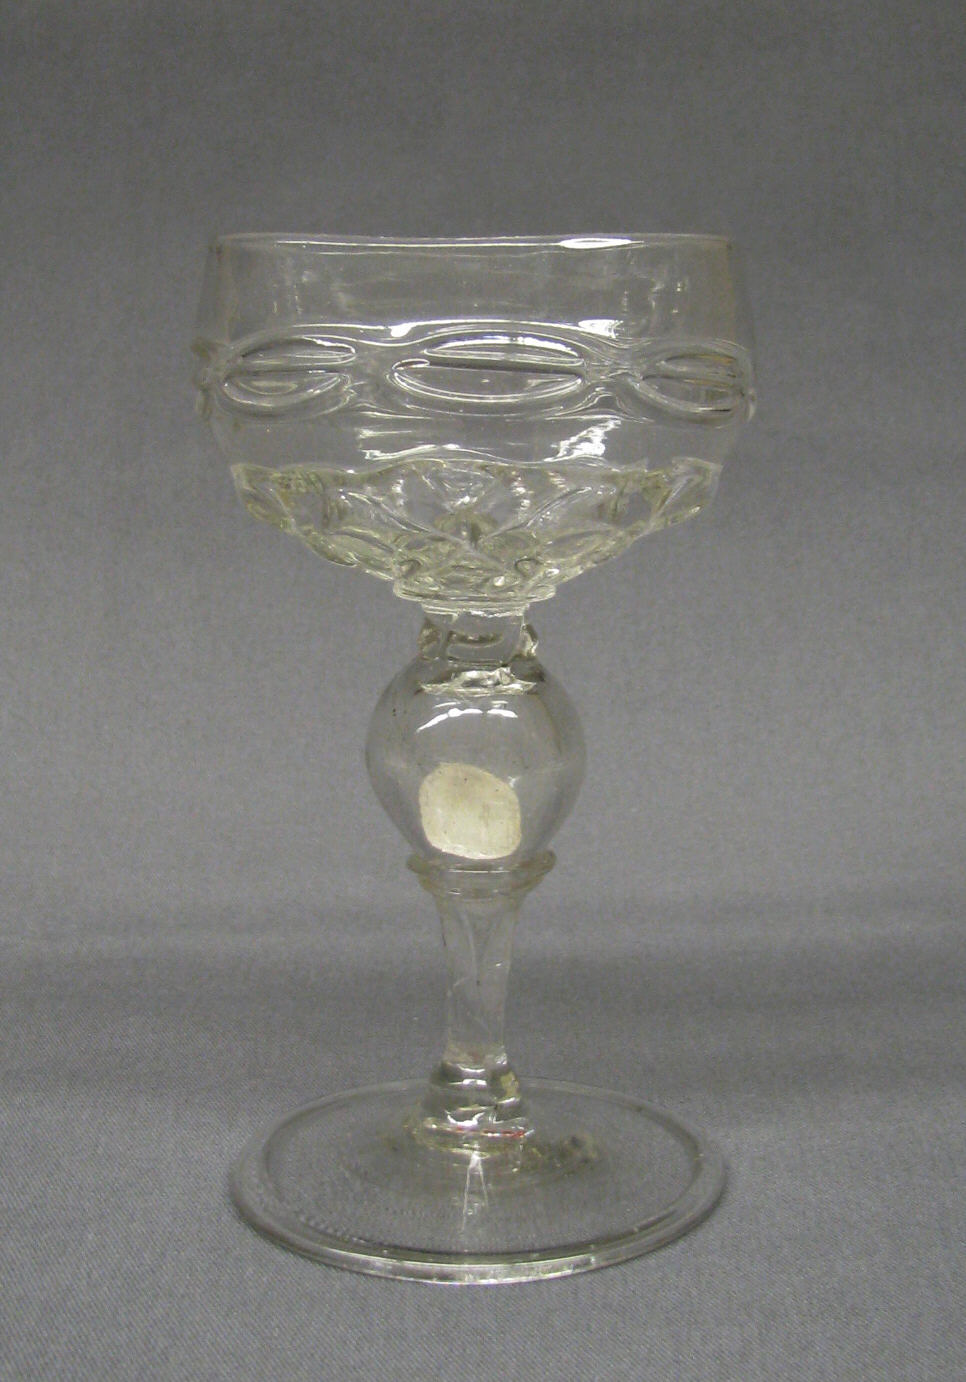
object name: wineglass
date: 1727-1730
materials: glass, silver